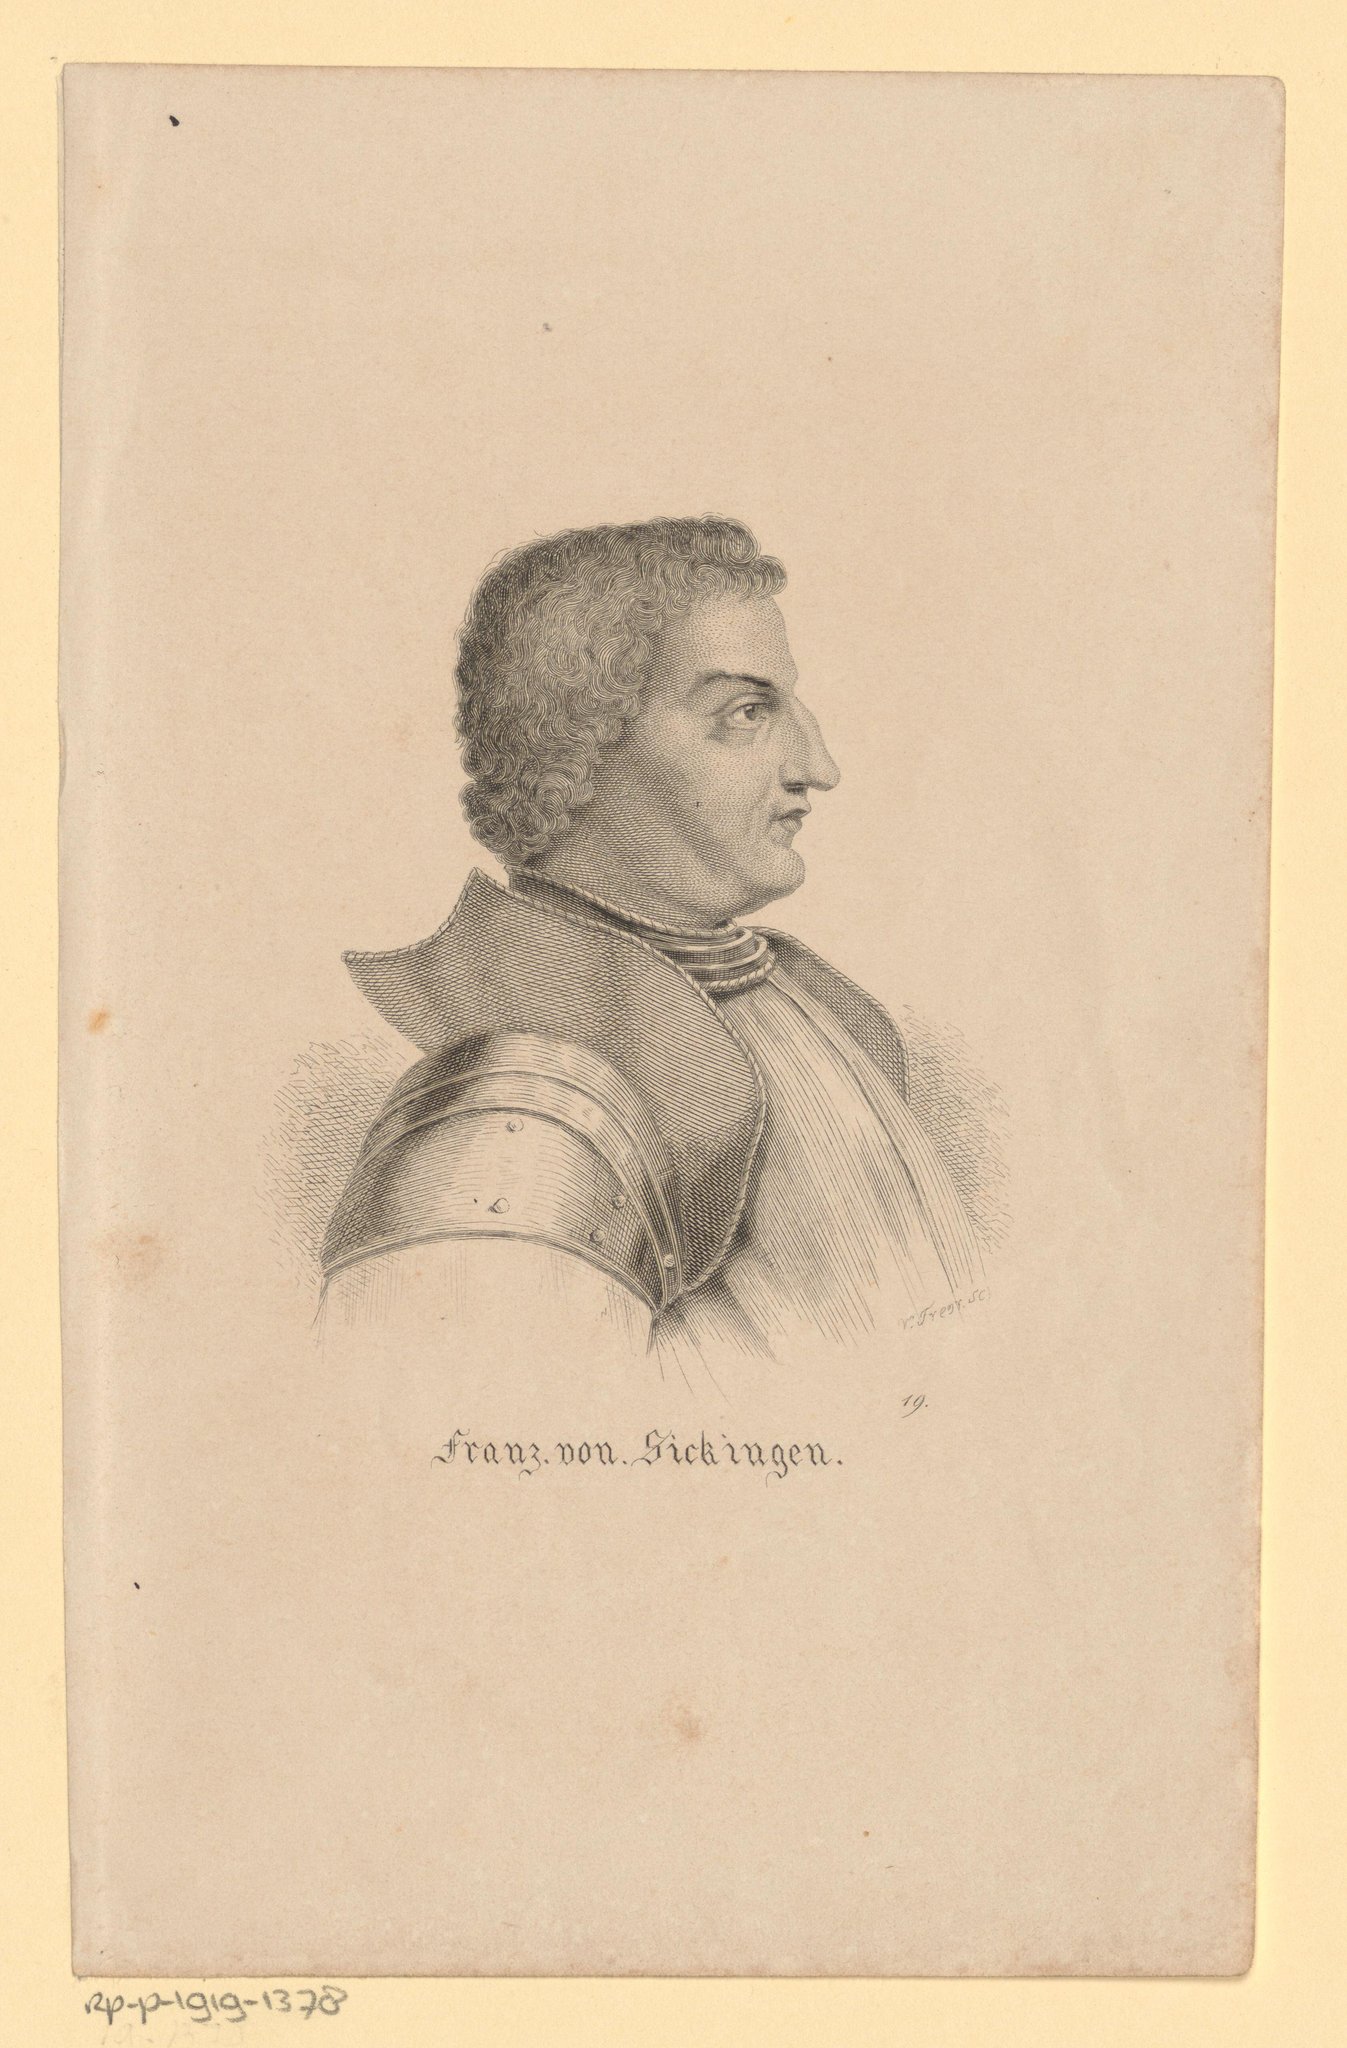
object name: print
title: Portret van Franz von Sickingen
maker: v. freyr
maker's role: print maker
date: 1750-1850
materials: paper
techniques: engraving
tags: armour, historical persons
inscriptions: collector's mark: Lugt 2228